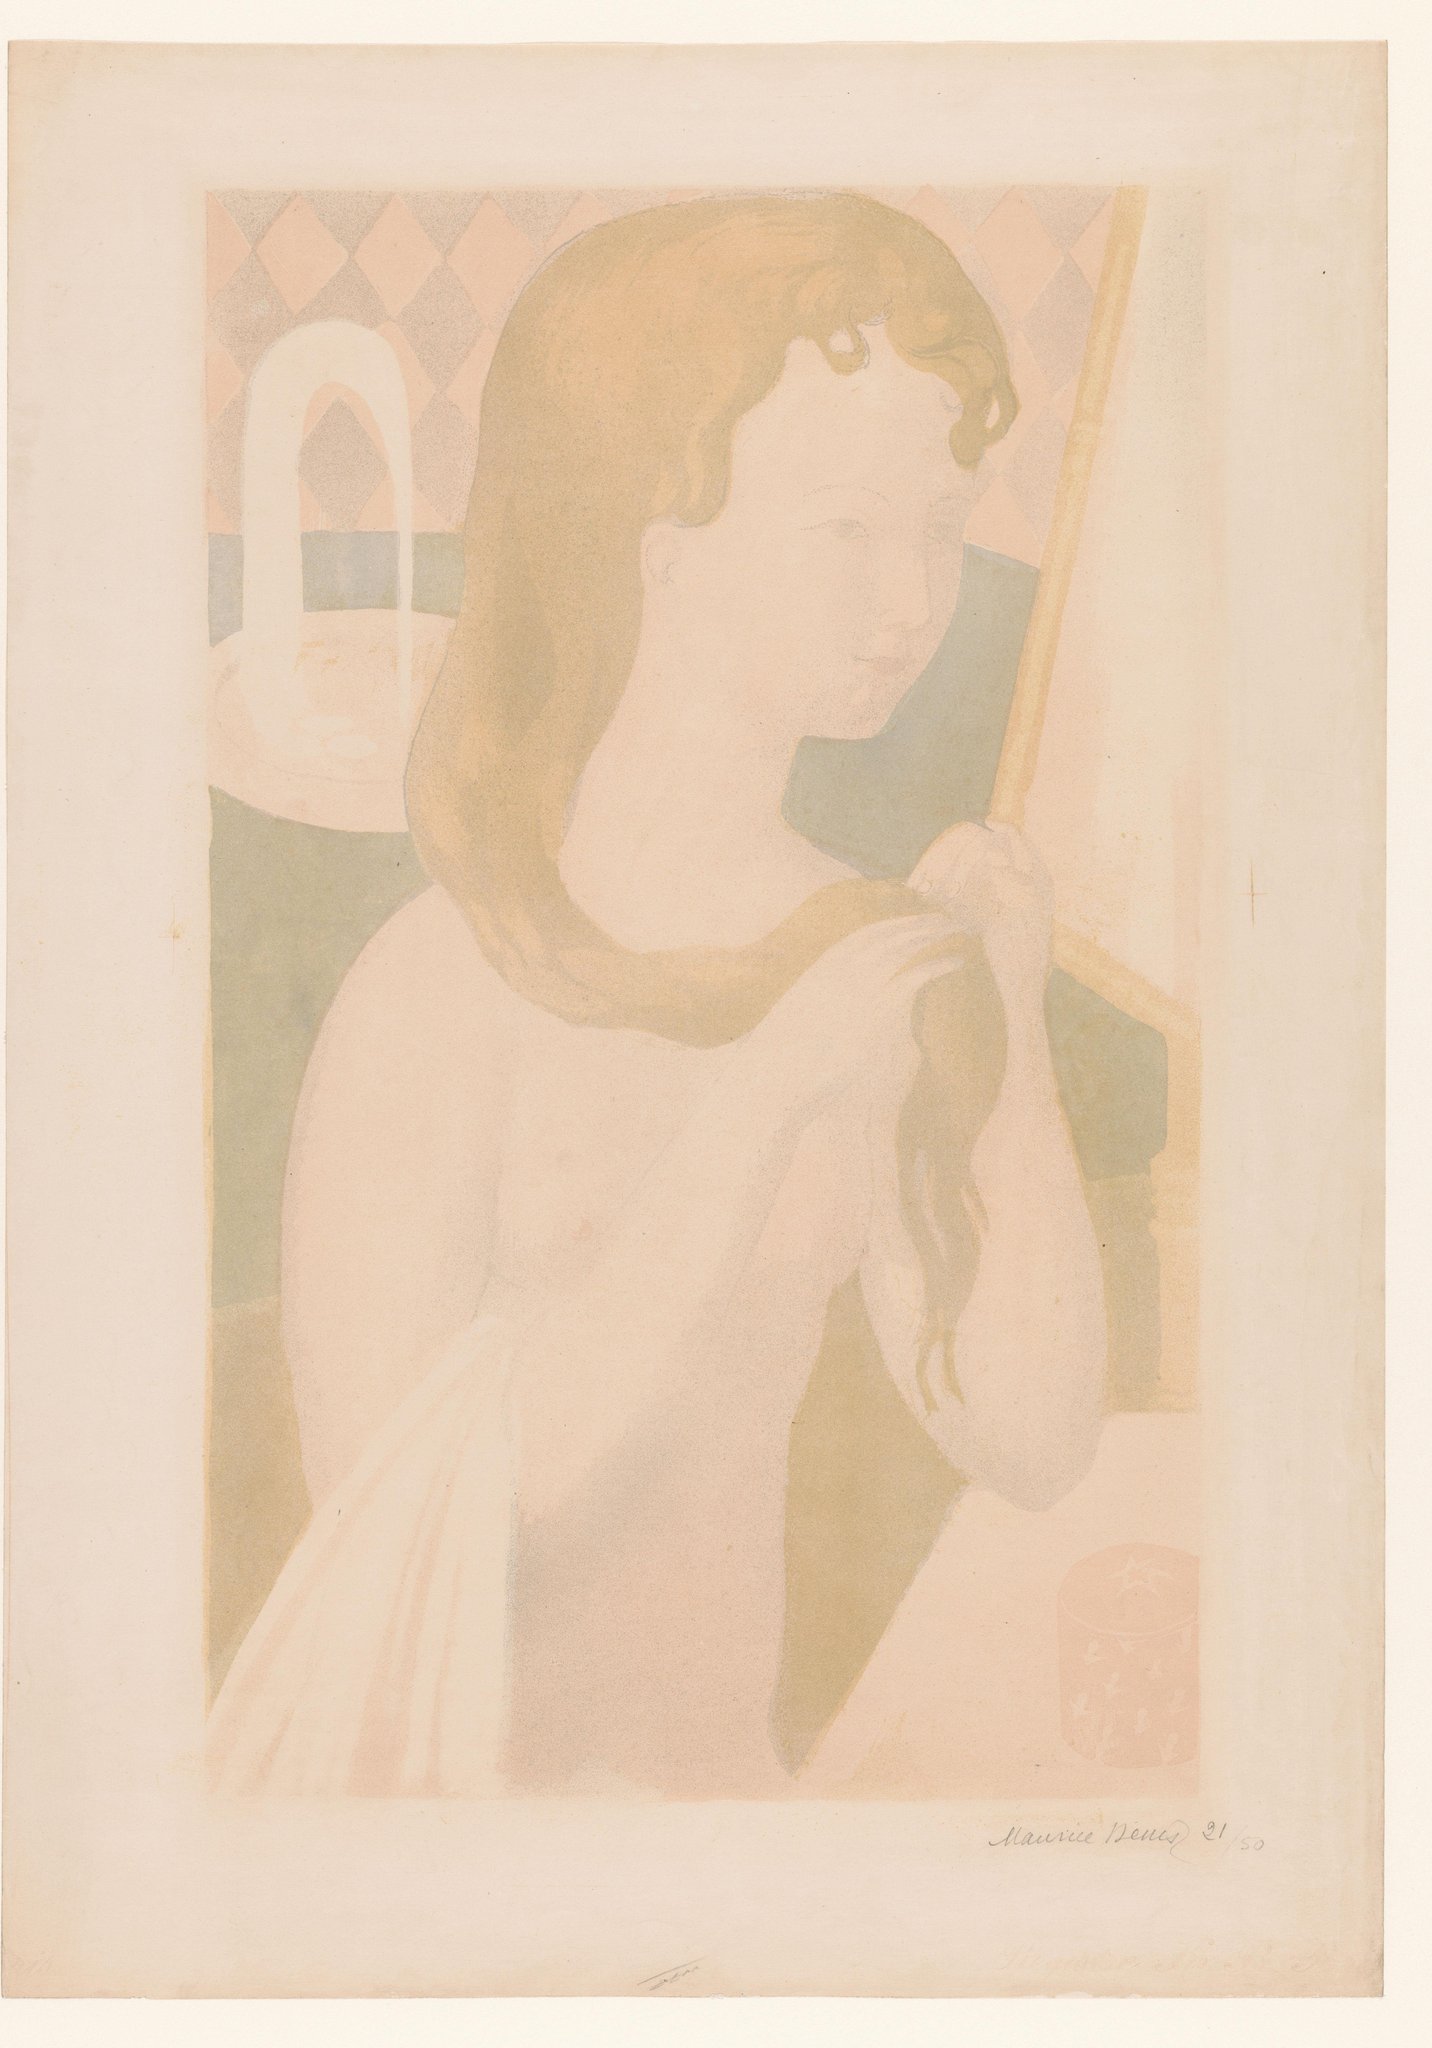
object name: print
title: Jeune fille à sa toilette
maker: maurice denis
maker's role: print maker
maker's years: 1870-1943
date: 1895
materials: paper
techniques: lithograph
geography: france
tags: adolescent, young woman, maiden, making toilet - aa - (for) women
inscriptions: collector's mark: Lugt 2760, collector's mark: Lugt 2228, check stamp: ‘Registre K B Paris’